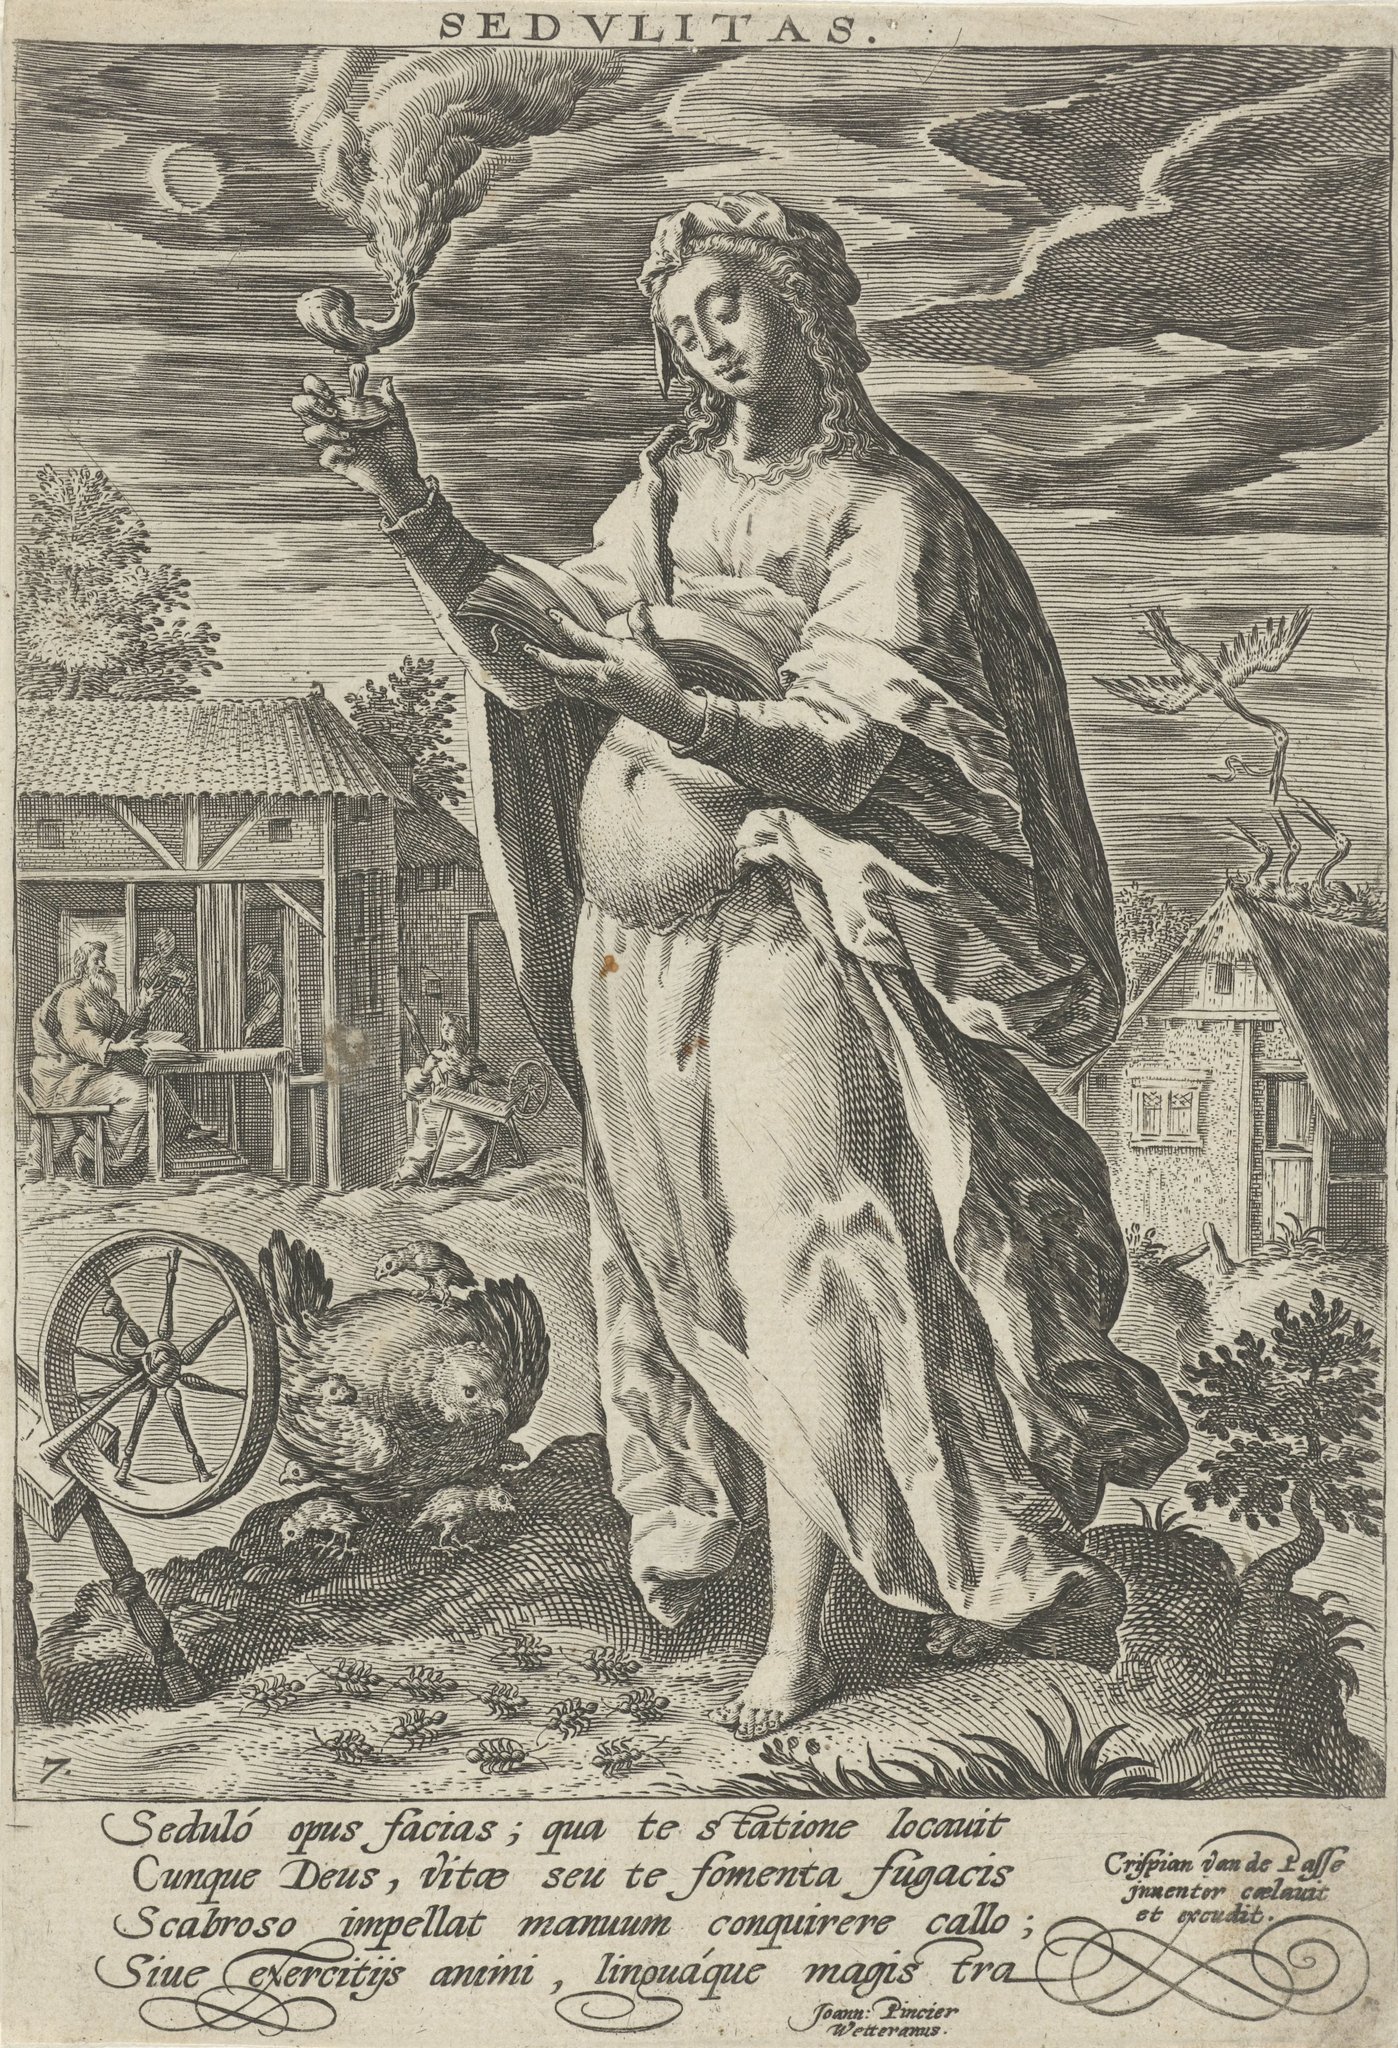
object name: print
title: Sedvlitas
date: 1589-1611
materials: paper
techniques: engraving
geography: cologne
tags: carefulness, diligence; 'diligenza' (ripa)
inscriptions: collector's mark: Lugt 2228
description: Landschap met de vrouwelijke personificatie van Arbeidzaamheid (Sedulitas), met een brandende olielamp en een opengeslagen boek in haar handen. Op de voorgrond mieren, een spinnewiel, en een kip met haar kuikens, die symbool staan voor vlijtig werken. Op de achtergrond een scène waarin deze deugd tot uiting komt: het spinnen van wol. Rechts op de achtergrond een ooievaar die haar jongen voedt. In de marge een vierregelig onderschrift in het Latijn. Zevende prent uit een serie met deugden.